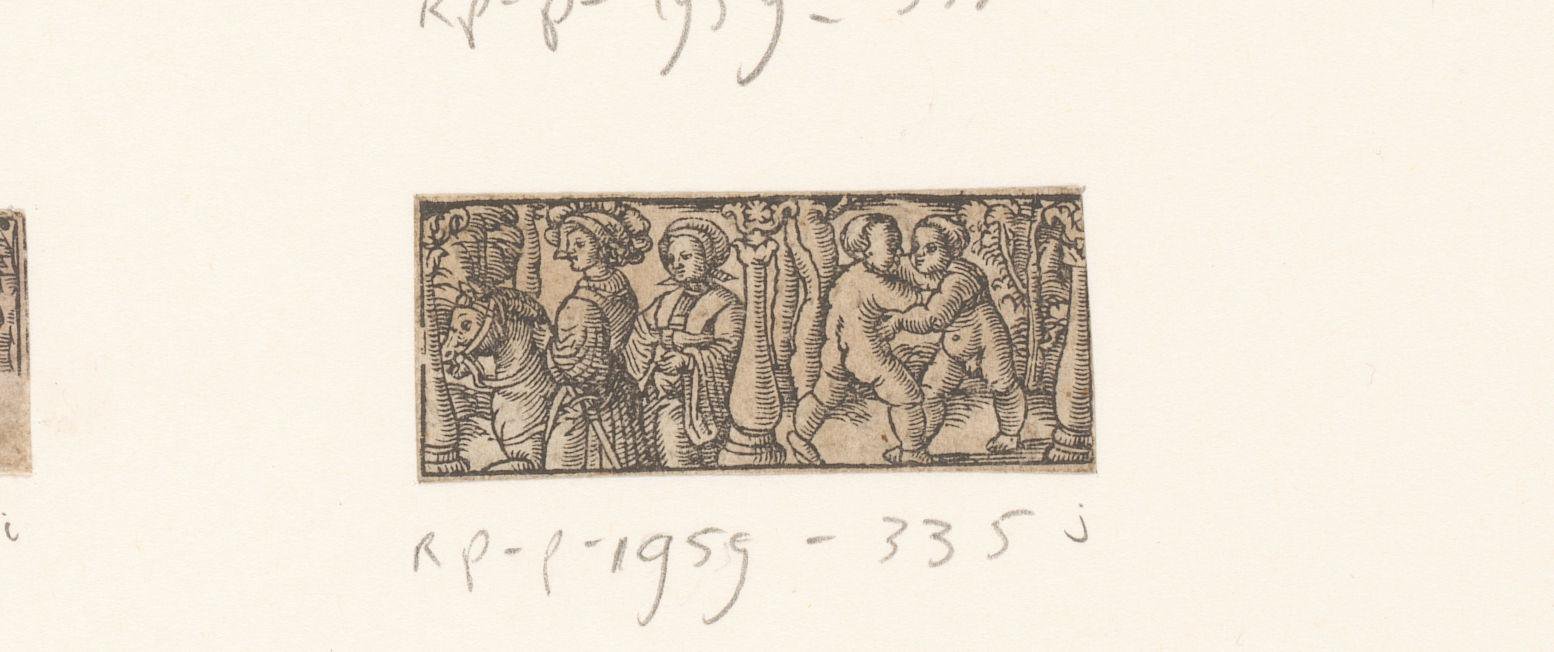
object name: print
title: Man en een vrouw te paard en het sterrenbeeld Tweelingen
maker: Anonymous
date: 1500-1599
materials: paper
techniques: woodcut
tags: gemini (zodiacal sign of may)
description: Prent afkomstig uit een onbekende publicatie.